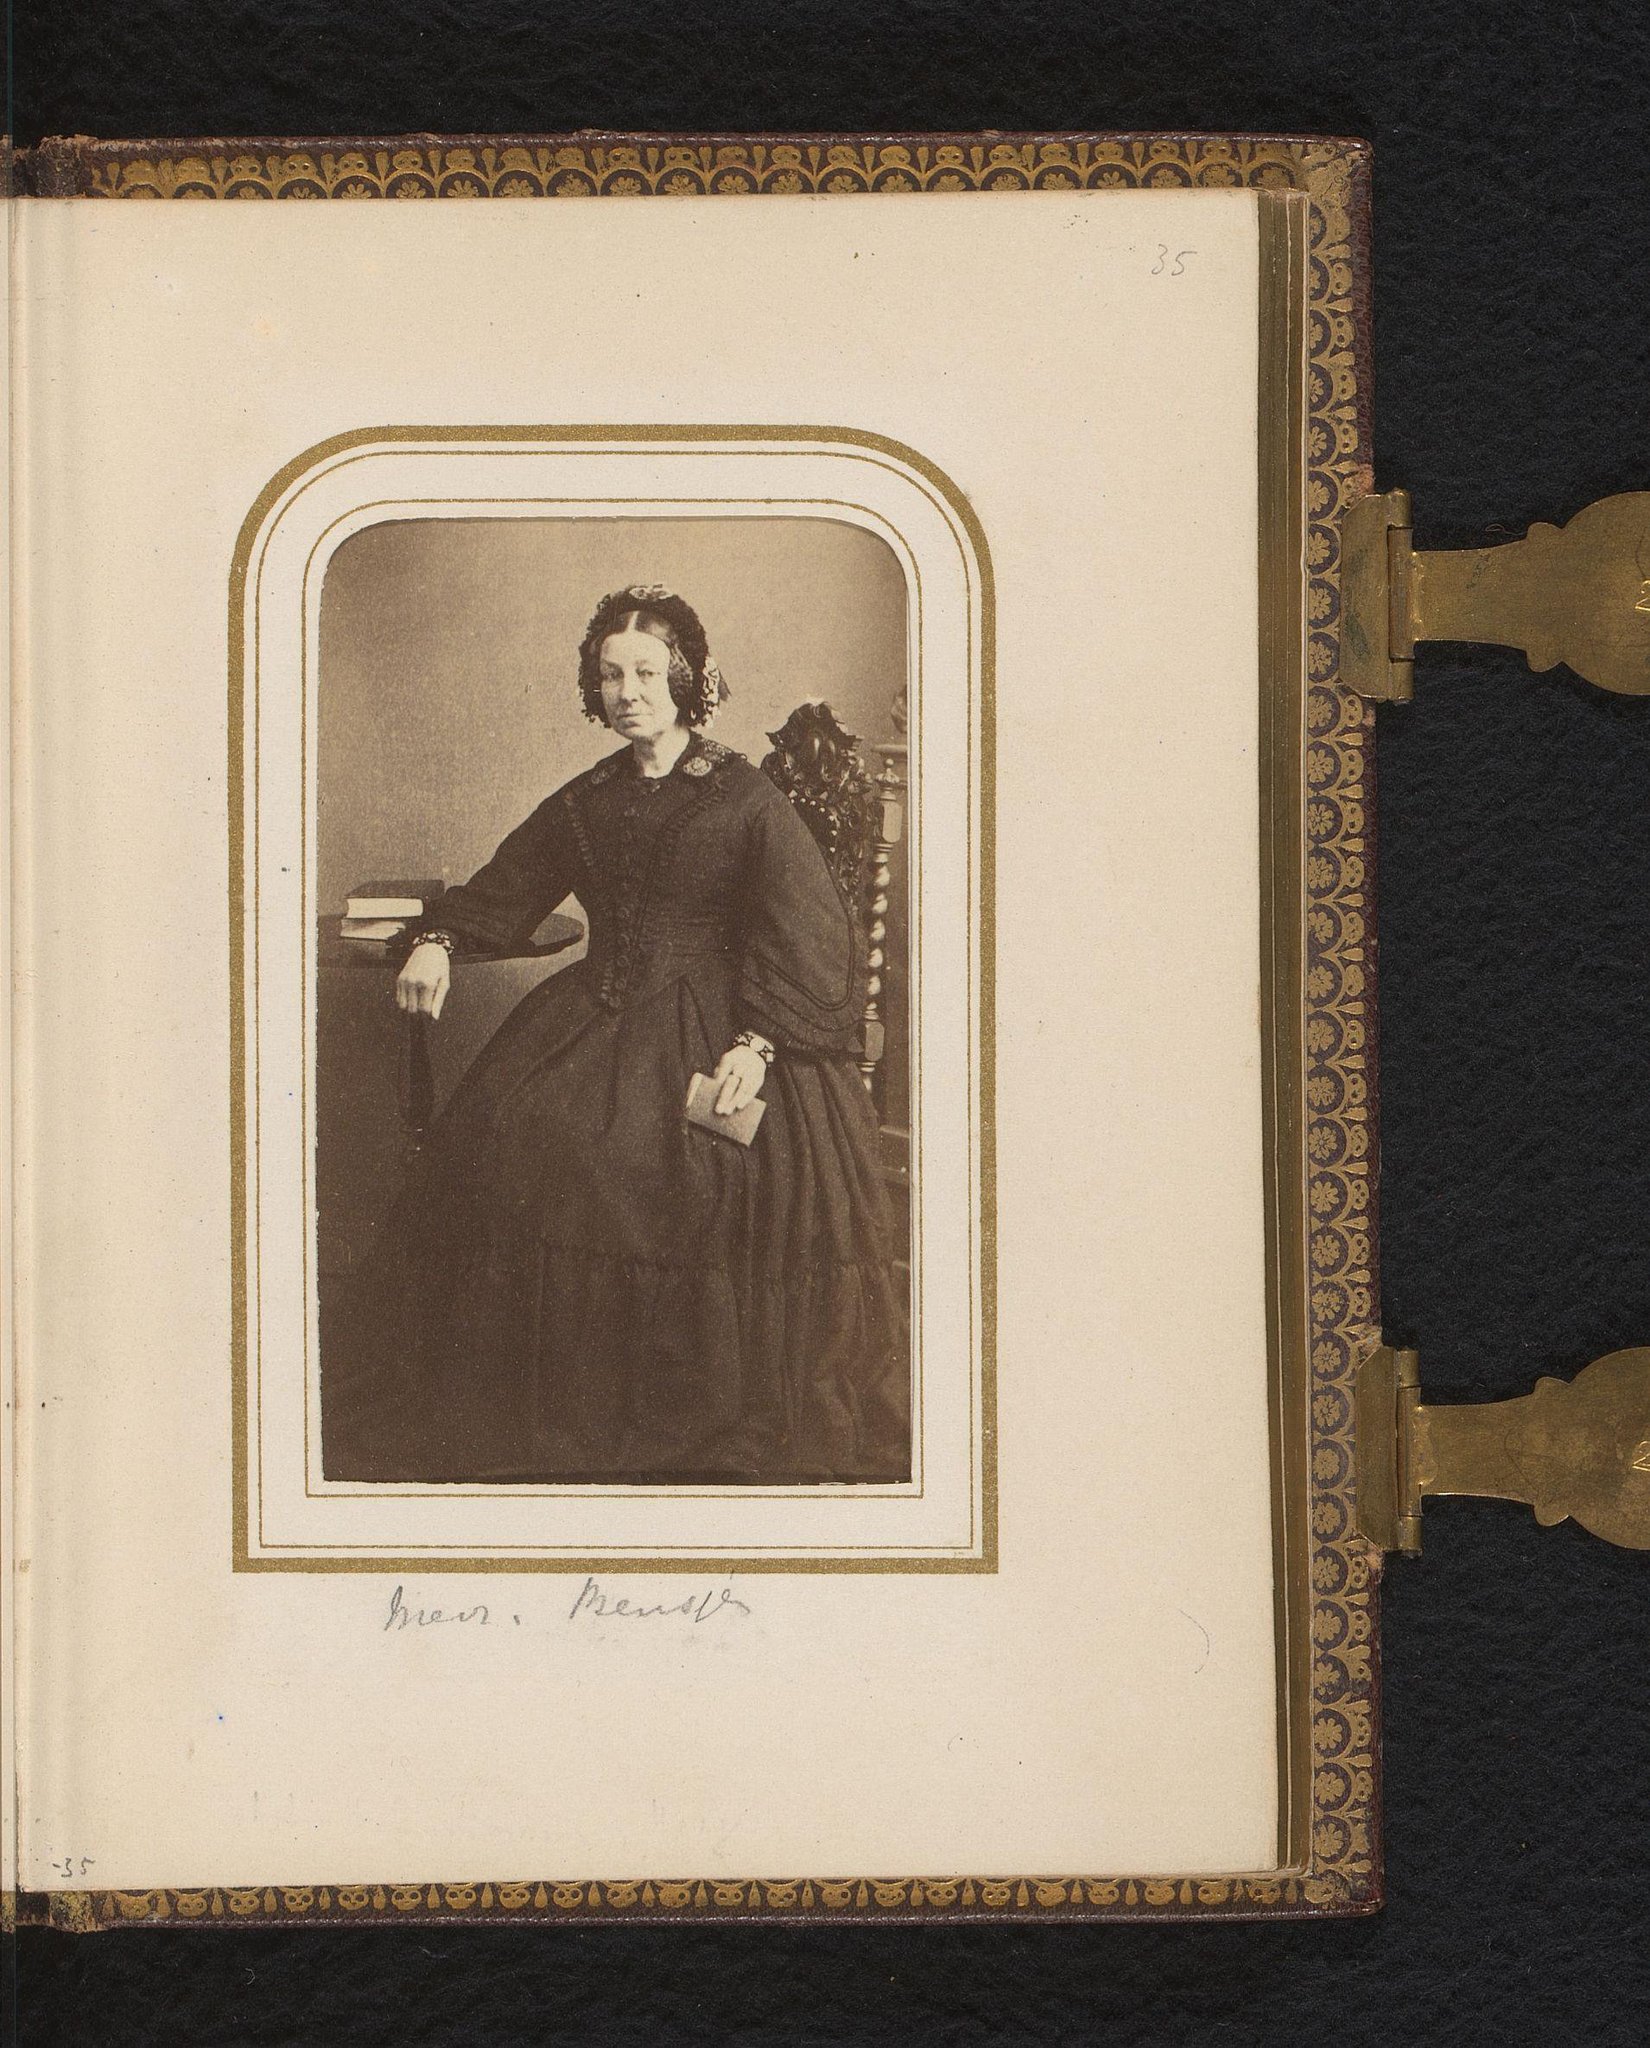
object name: photograph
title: Mevr. Bensjes [?]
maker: herman bückmann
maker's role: fotograaf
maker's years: 1820-1884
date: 1860-1870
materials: cardboard, paper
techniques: albumen print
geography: the hague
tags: anonymous historical person portrayed - bb - woman